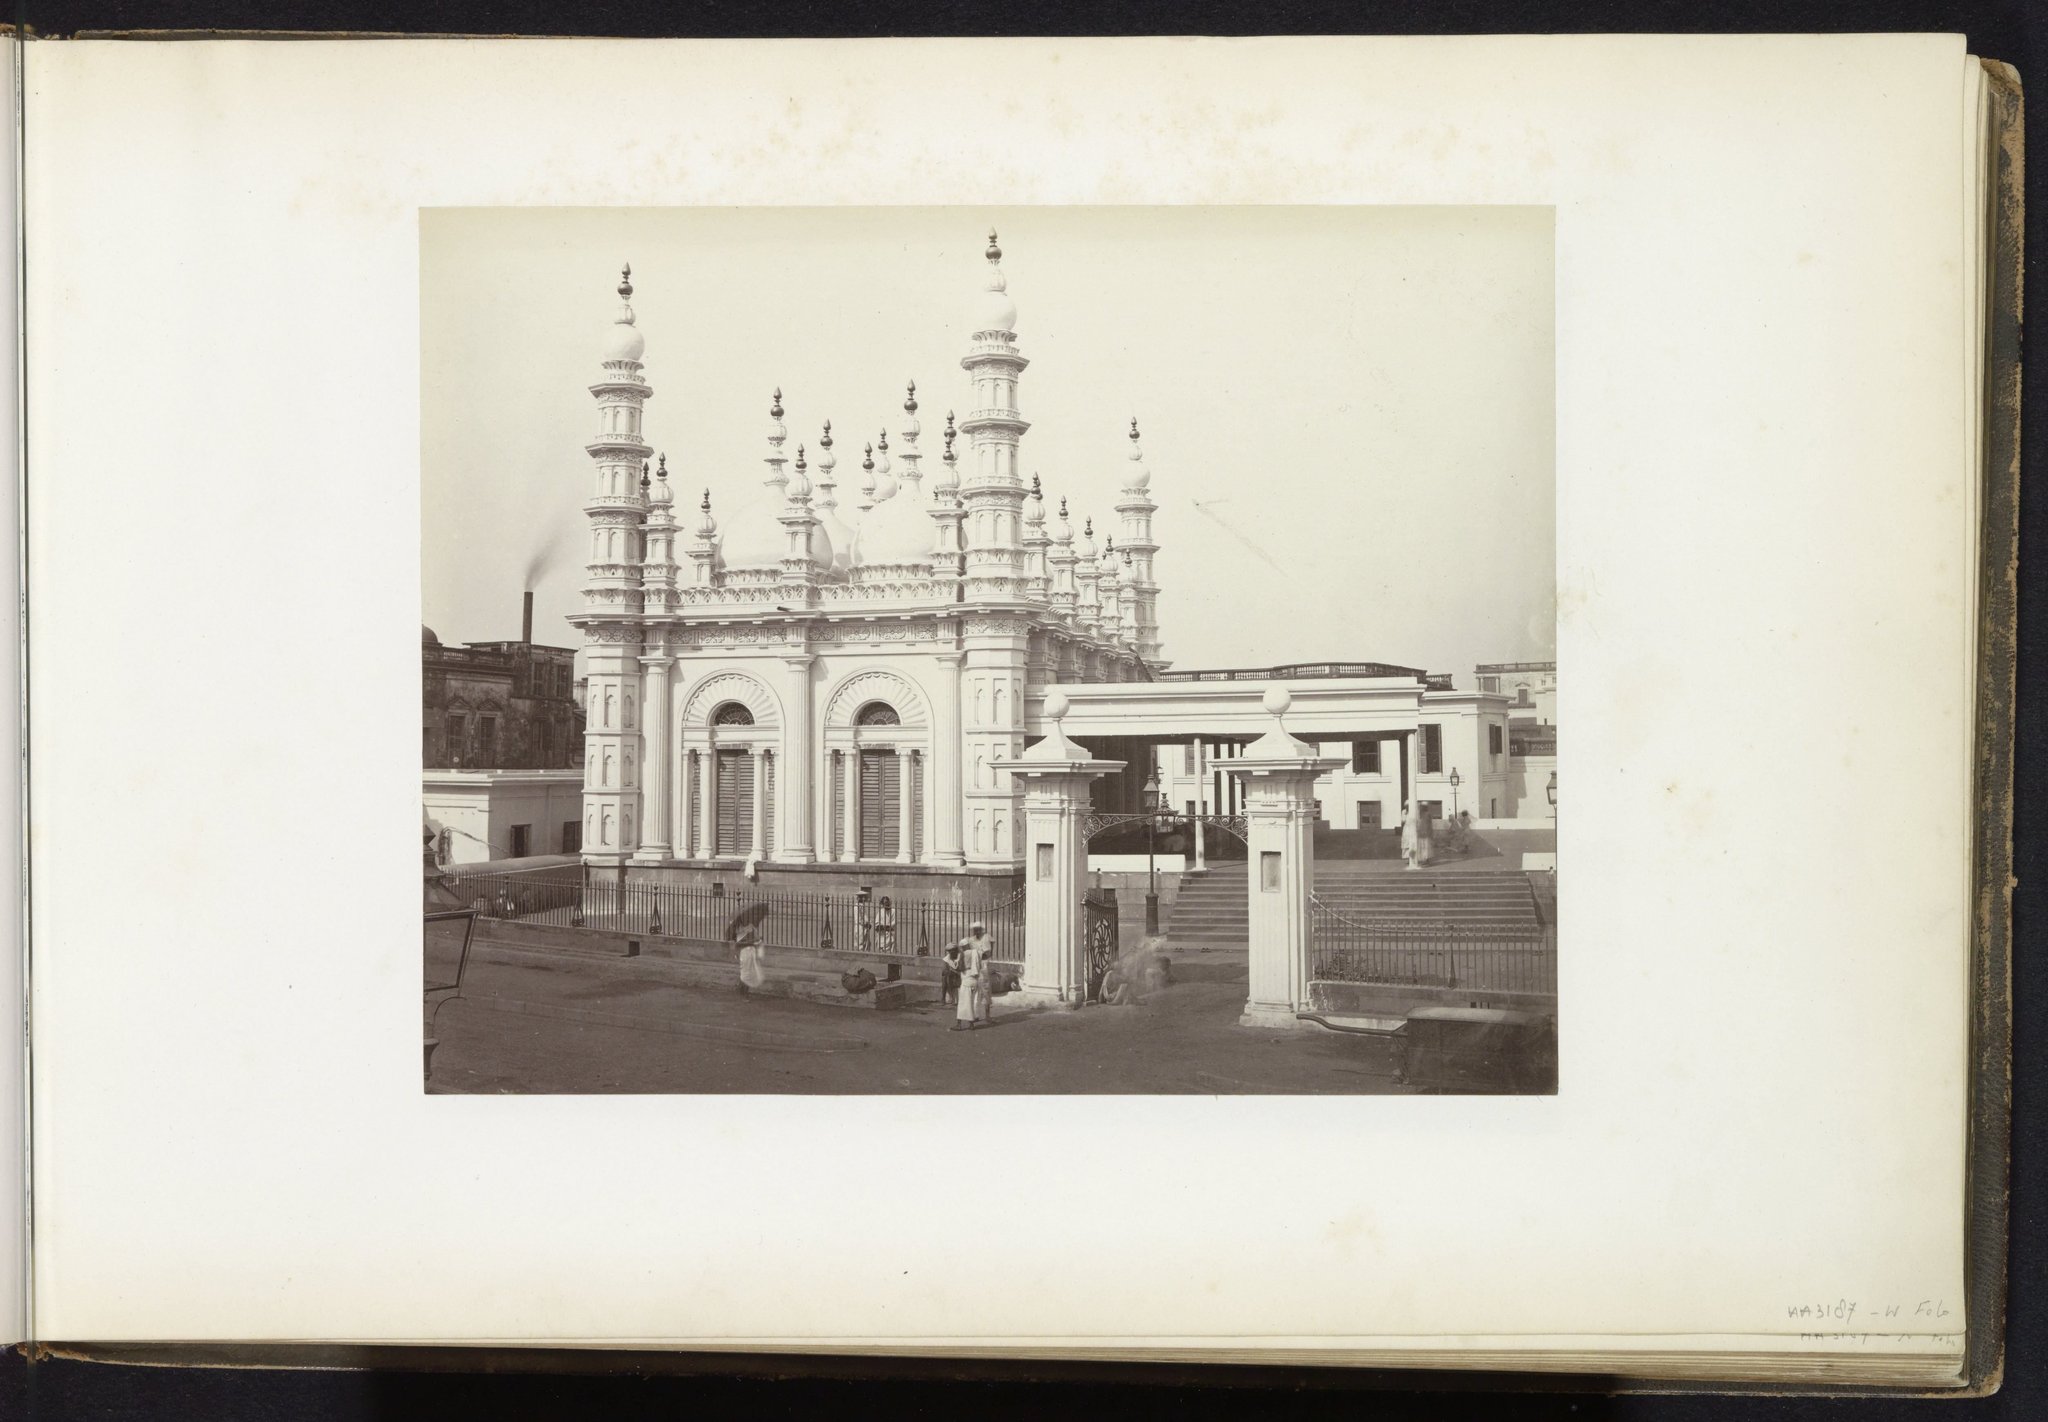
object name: photograph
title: Exterior of the Tipu Sultan Shahi mosque in Kolkata, West Bengal, India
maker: Anonymous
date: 1865-1875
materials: photographic support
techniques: albumen print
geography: kolkata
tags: temple, shrine ~ islam, mohammedanism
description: Onderdeel van Reisalbum met opnames van bezienswaardigheden in India, Duitsland, Zwitserland en Frankrijk.